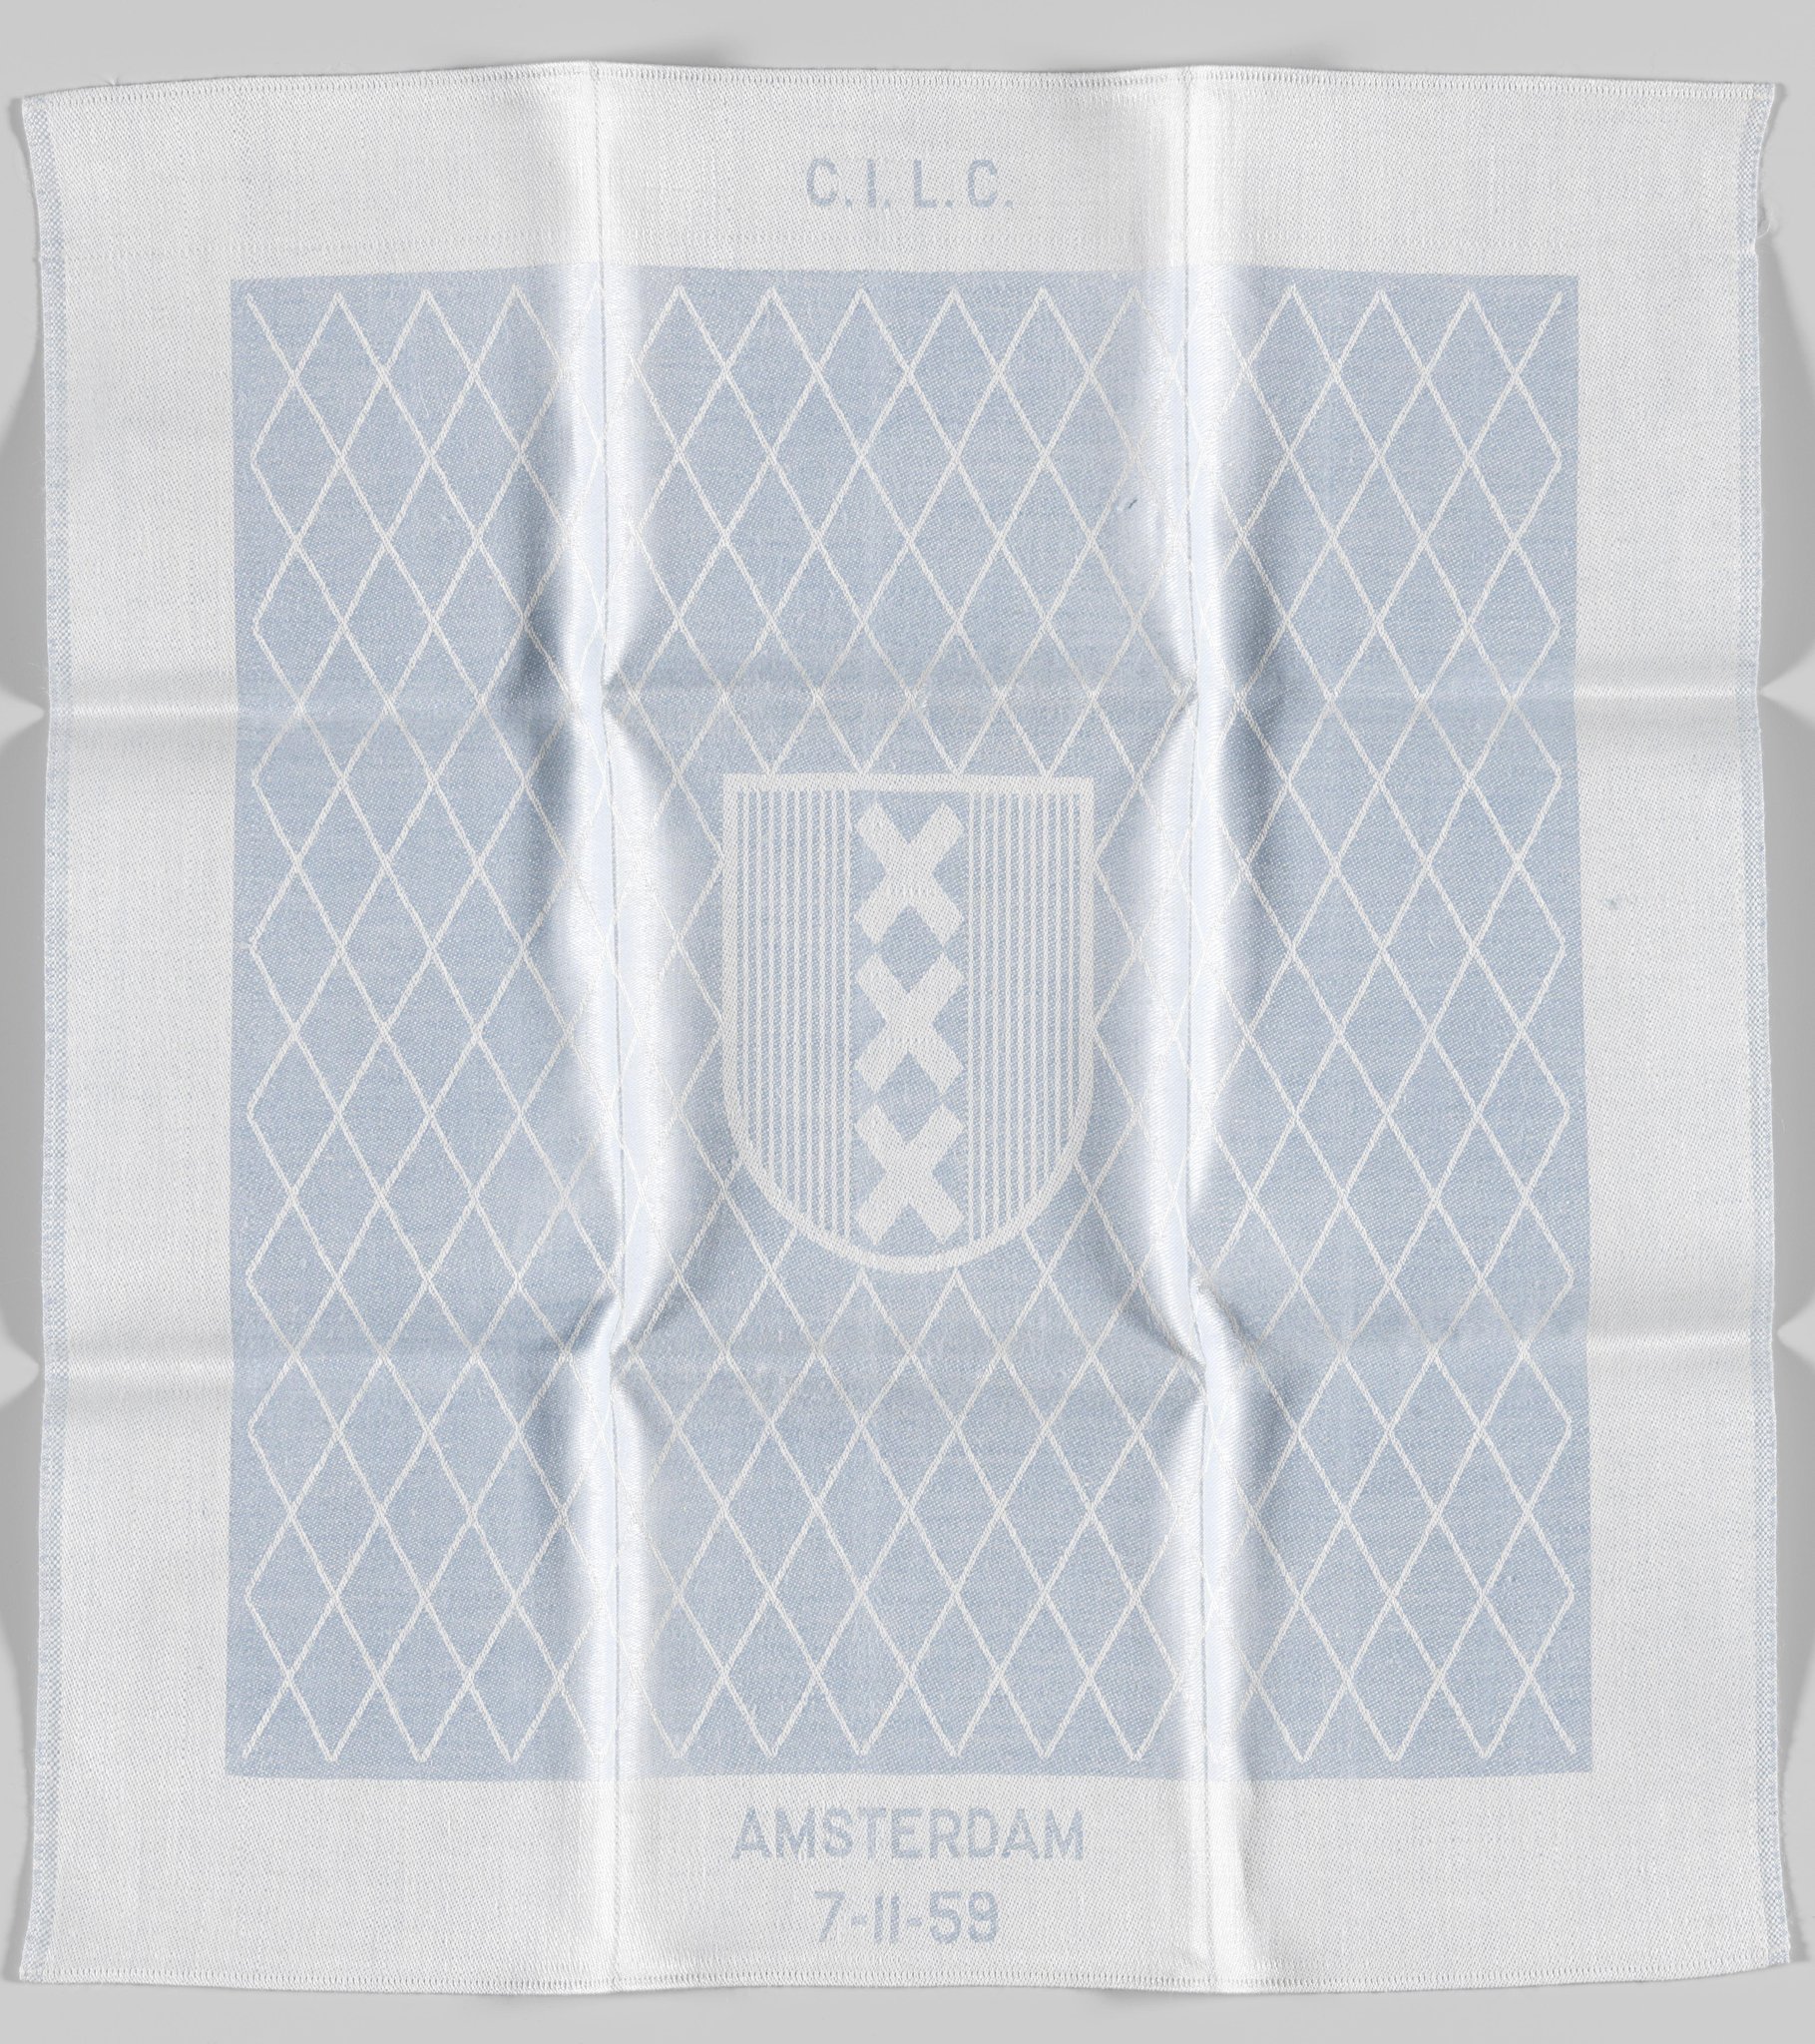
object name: vingerdoek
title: Vingerdoek van lichtblauw linnendamast met wapen van Amsterdam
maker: Anonymous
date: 1959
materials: linen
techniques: damask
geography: eindhoven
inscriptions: inscription: ‘Amsterdam 7-11-59’, inscription: ‘C.I.L.C.’, coat of arms: ‘Drie Andreaskruizen op wapen schild (Amsterdam)’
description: Vingerdoek van lichtblauw linnendamast met wapen van Amsterdam op geruit fond. In de zomen de tekst "C.I.L.C. AMSTERDAM 7-11-59".